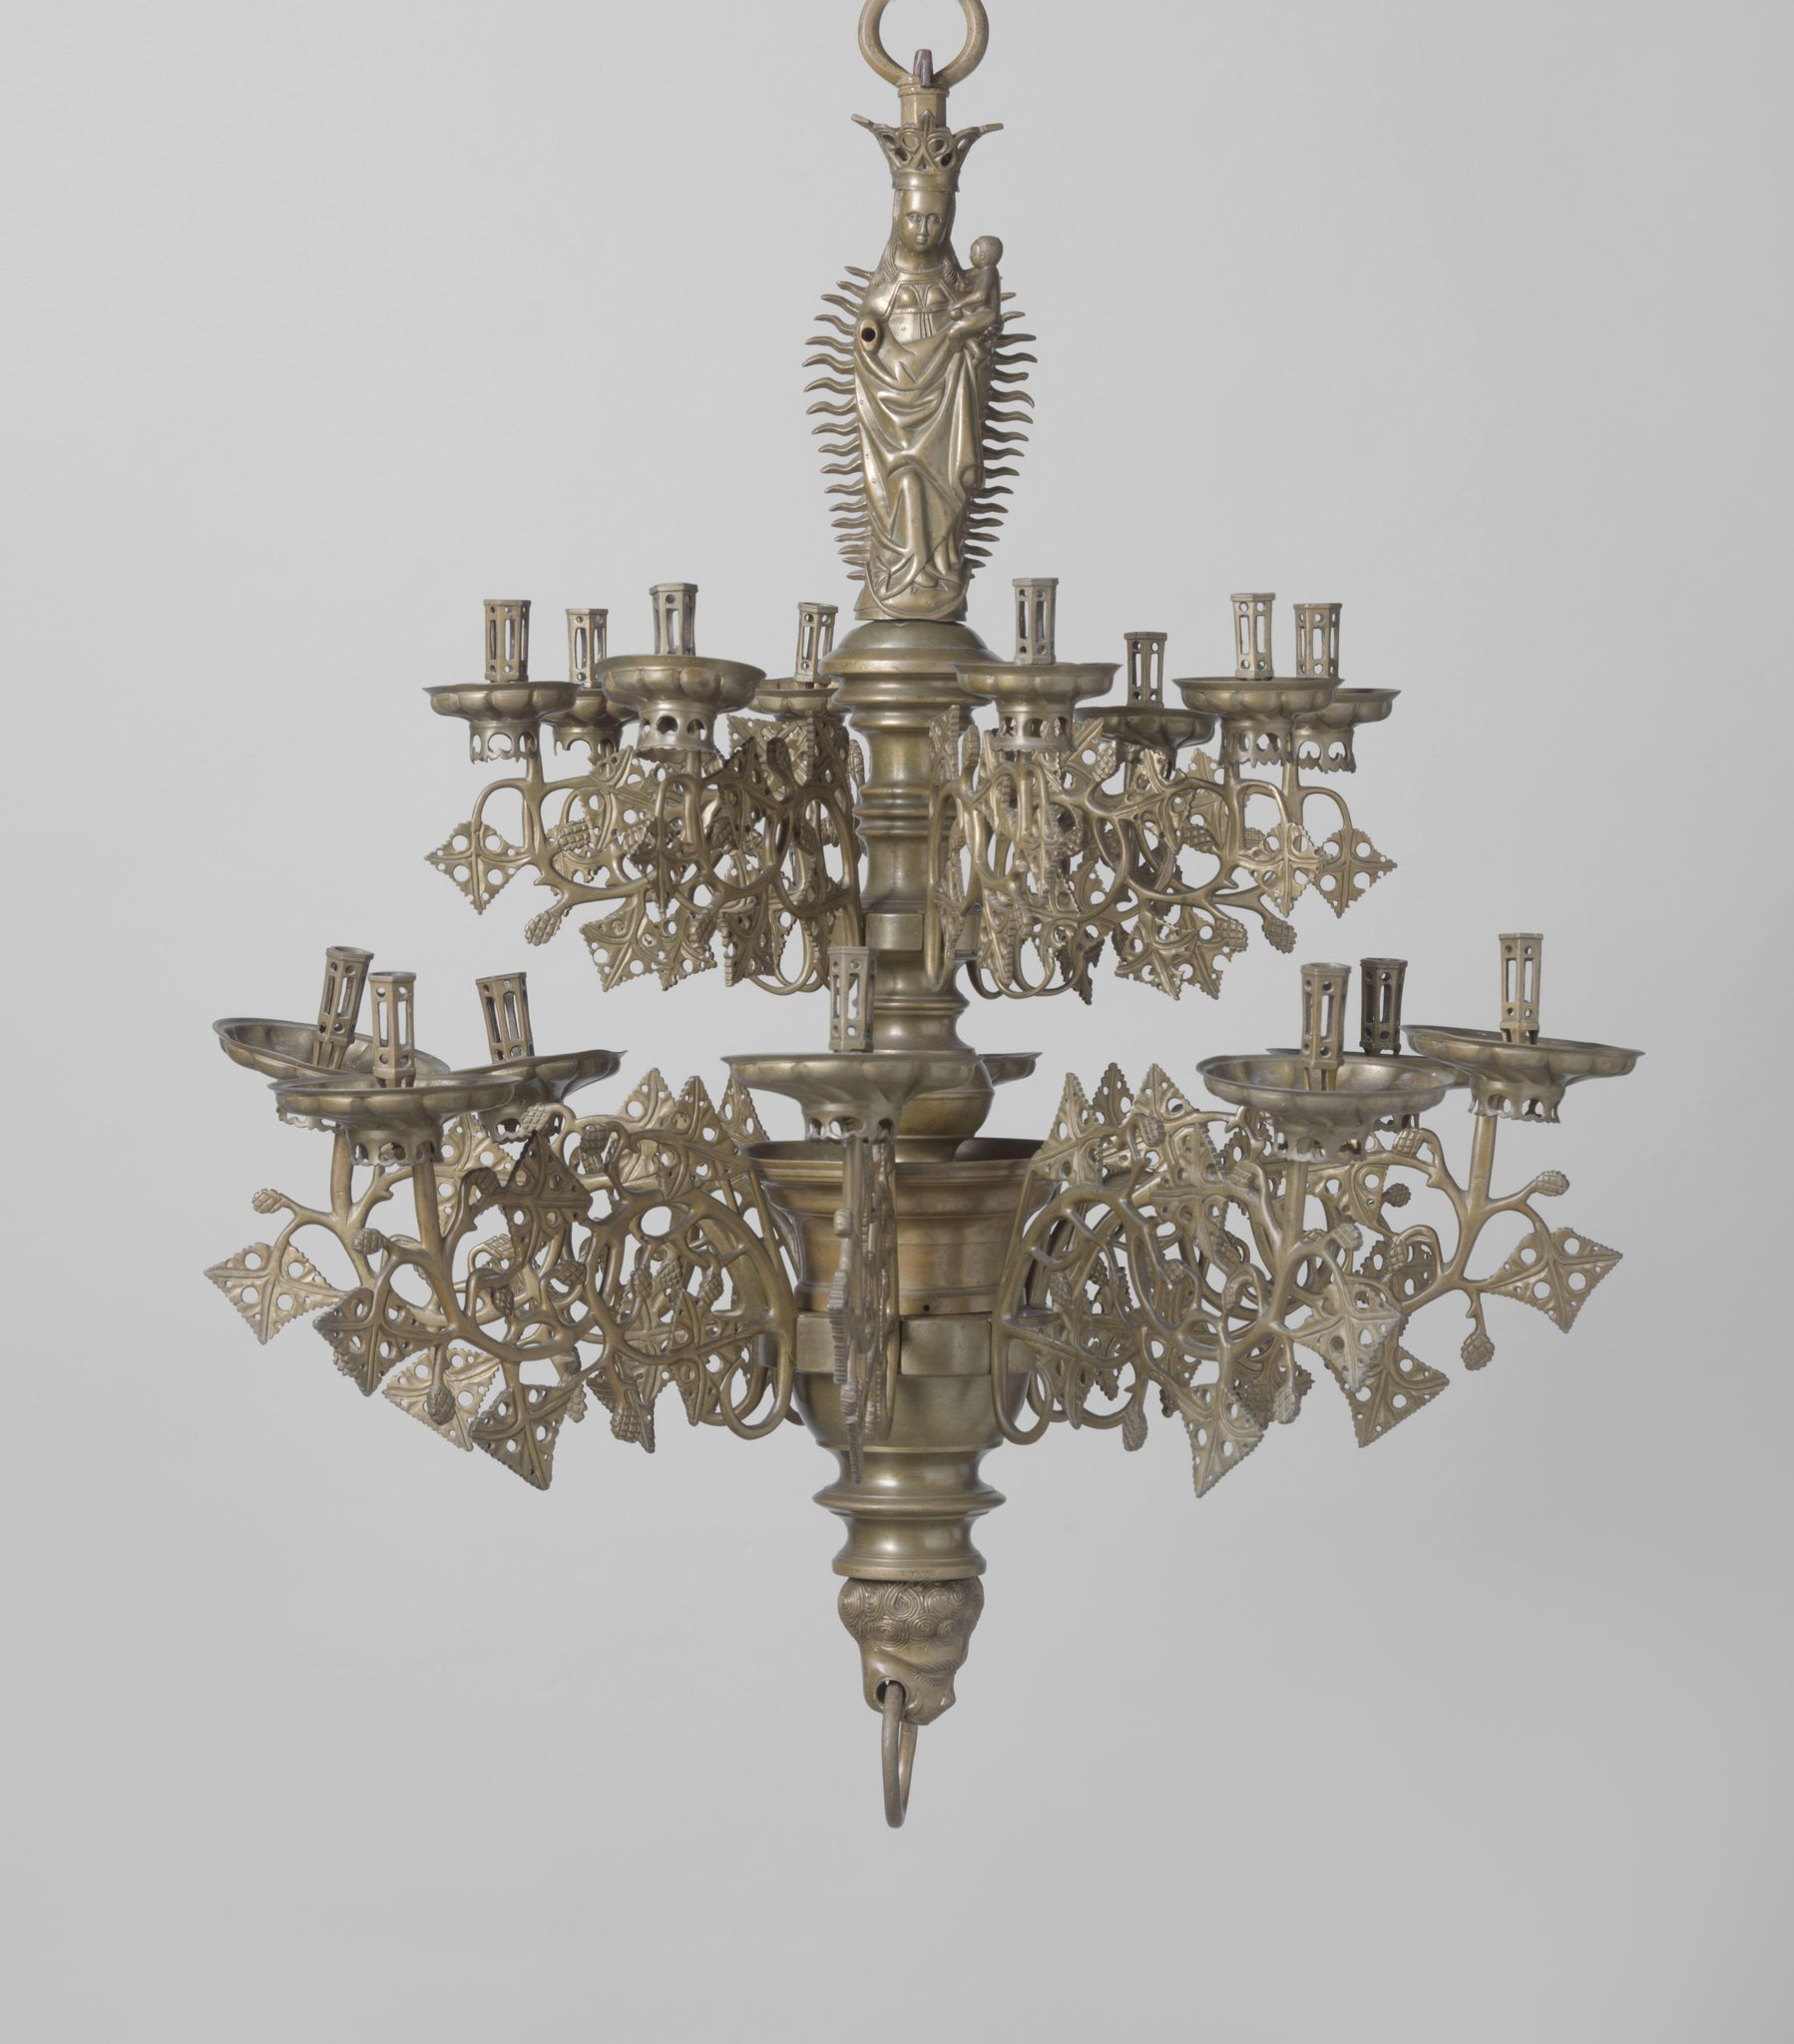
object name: chandelier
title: Arm met kaarsenhouder van kaarsenkroon van twee hoogten met ieder acht armen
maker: Anonymous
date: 1525-1550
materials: brass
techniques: casting, screwed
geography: southern netherlands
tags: vine-tendril, leaf, mary standing (or half-length), the christ-child sitting on her arm (christ-child to mary's left)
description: Kaarsenarm behorende bij een kaarsenkroon van twee hoogten met Mariafiguur bovenaan. De arm is twee maal gebogen en is versierd met vier druiventrossen en vijf wingerdbladeren. De ronde vetvanger is aan de onderkant versierd met visblaasmotieven en heeft naar het midden toe een naar beneden uitstekende rand van kruisbloemen, die de plaatsing op de arm maskeert. De kaarsenhouder is zesvlakkig, opengewerkt, geplaatst op drie verticale stijlen, overgaande in een uitsteeksel met schroefdraad. Dit is de tweede arm van de bovenste ring, genummerd met 3 ronde punten. De kaarsenhouder is ongenummerd.